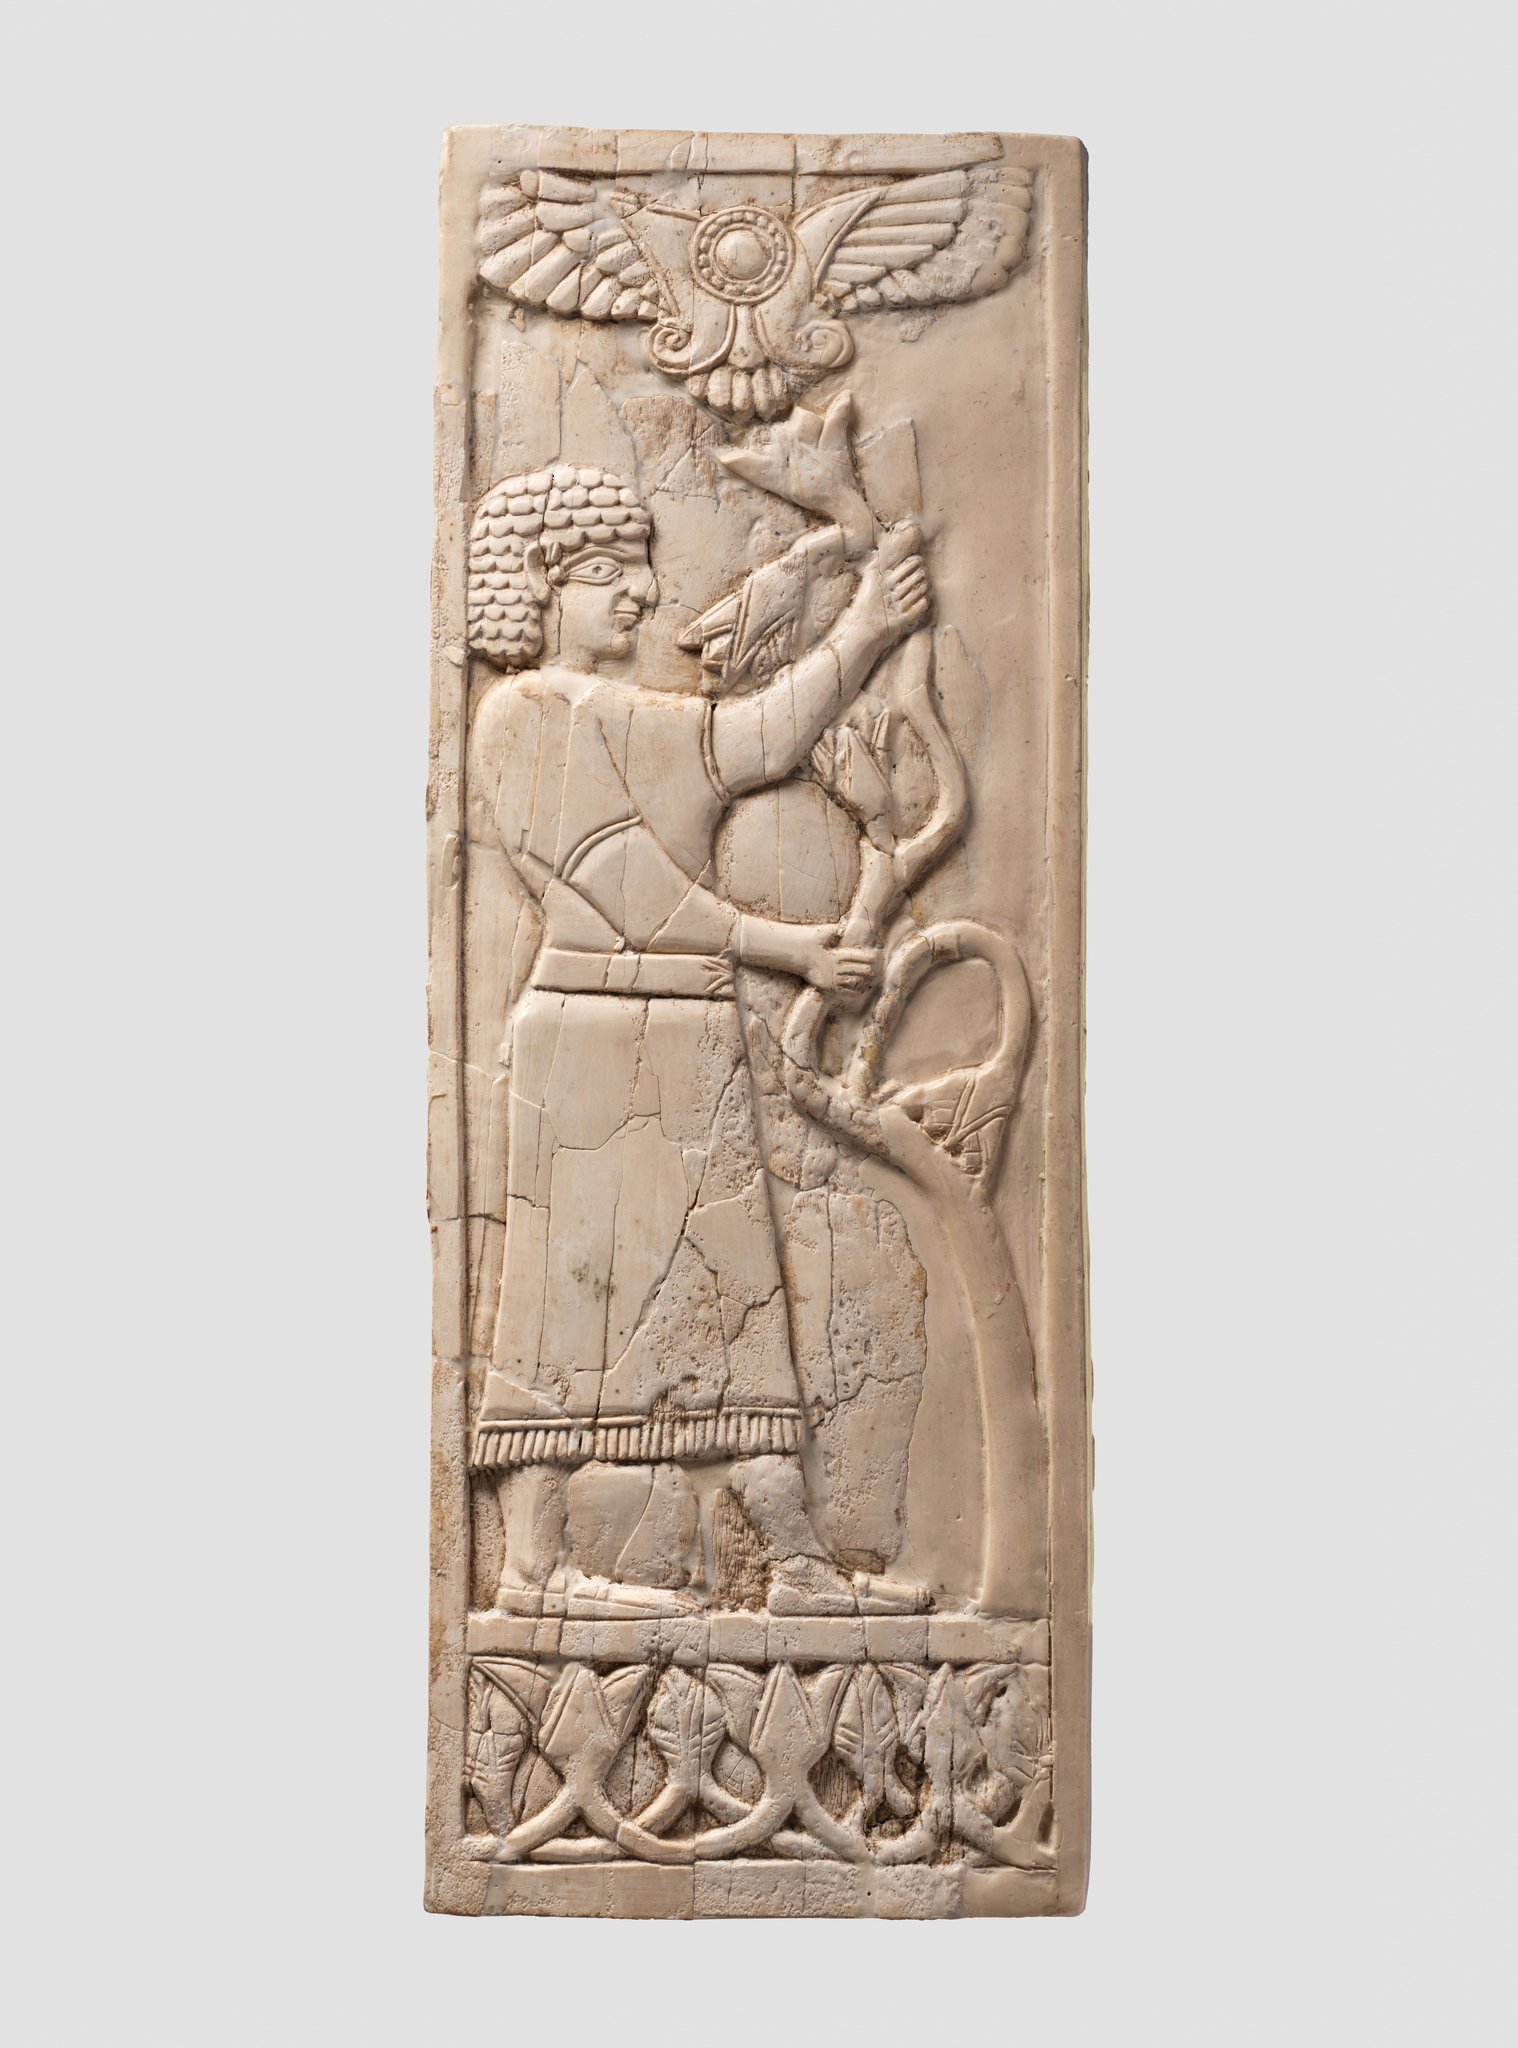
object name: relief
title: Panel with a youth grasping a tree; winged sun disc above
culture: assyrian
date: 800-701 BCE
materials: ivory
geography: mesopotamia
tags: men,lotuses,trees